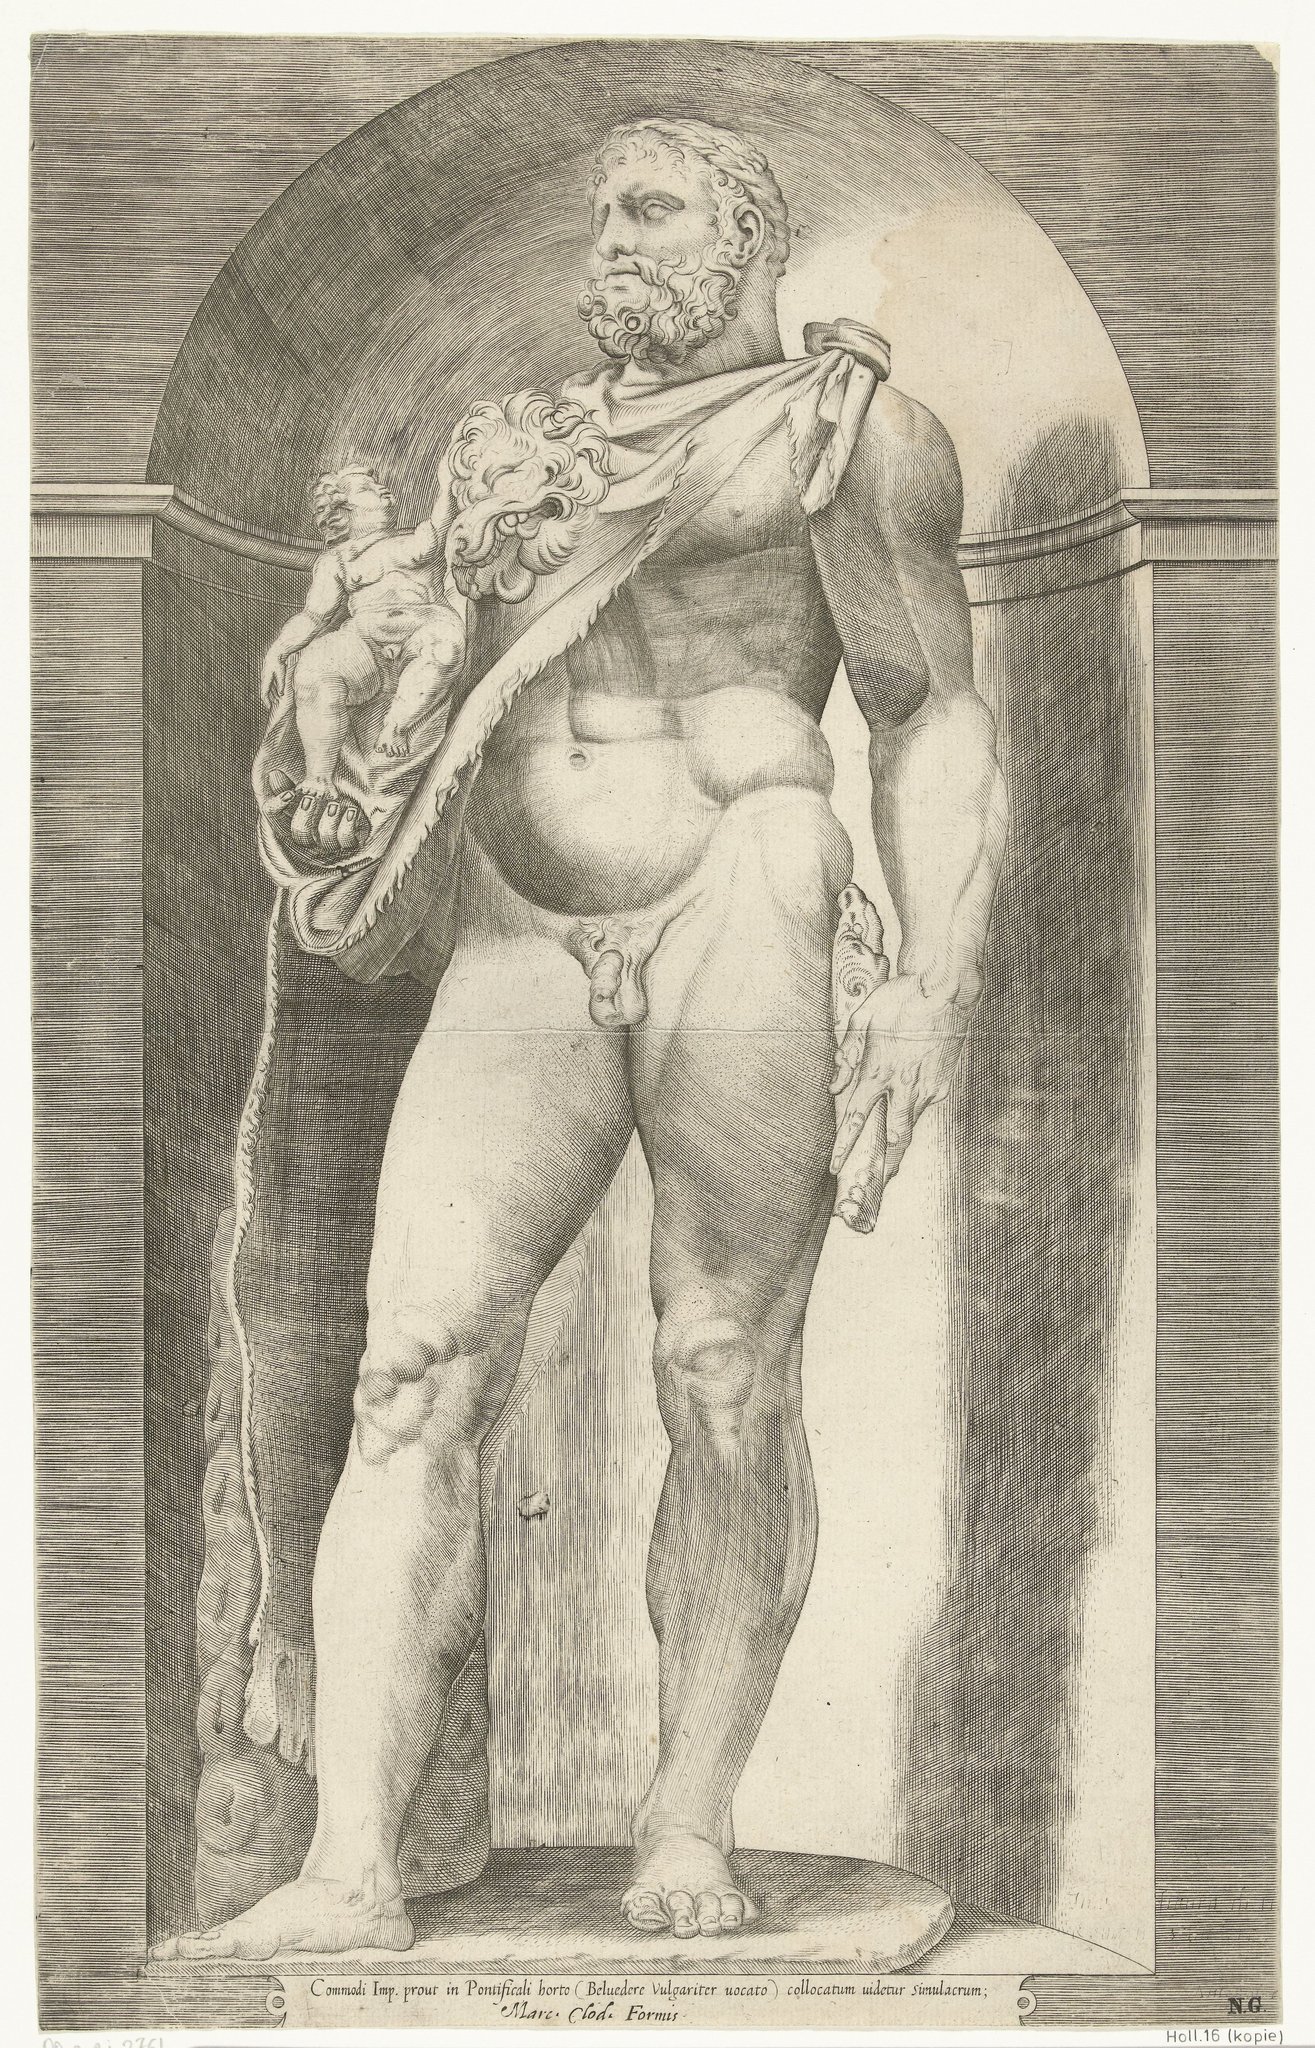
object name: print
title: Standbeeld van keizer Commodus als Hercules,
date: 1550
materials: paper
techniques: engraving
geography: rome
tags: (story of) hercules (heracles), piece of sculpture, reproduction of a piece of sculpture, (story of) commodus the roman emperor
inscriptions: collector's mark: Lugt 1967 of1968, collector's mark: Lugt 2228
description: Standbeeld van keizer Commodus als Hercules. Hercules is naakt en zwaargebouwd. Hij draagt zijn leeuwenhuid als mantel. Op zijn linkerarm zit zijn zoon Telephos. Het beeld staat nu in het Vaticaans museum. De prent heeft een Latijns onderschrift.